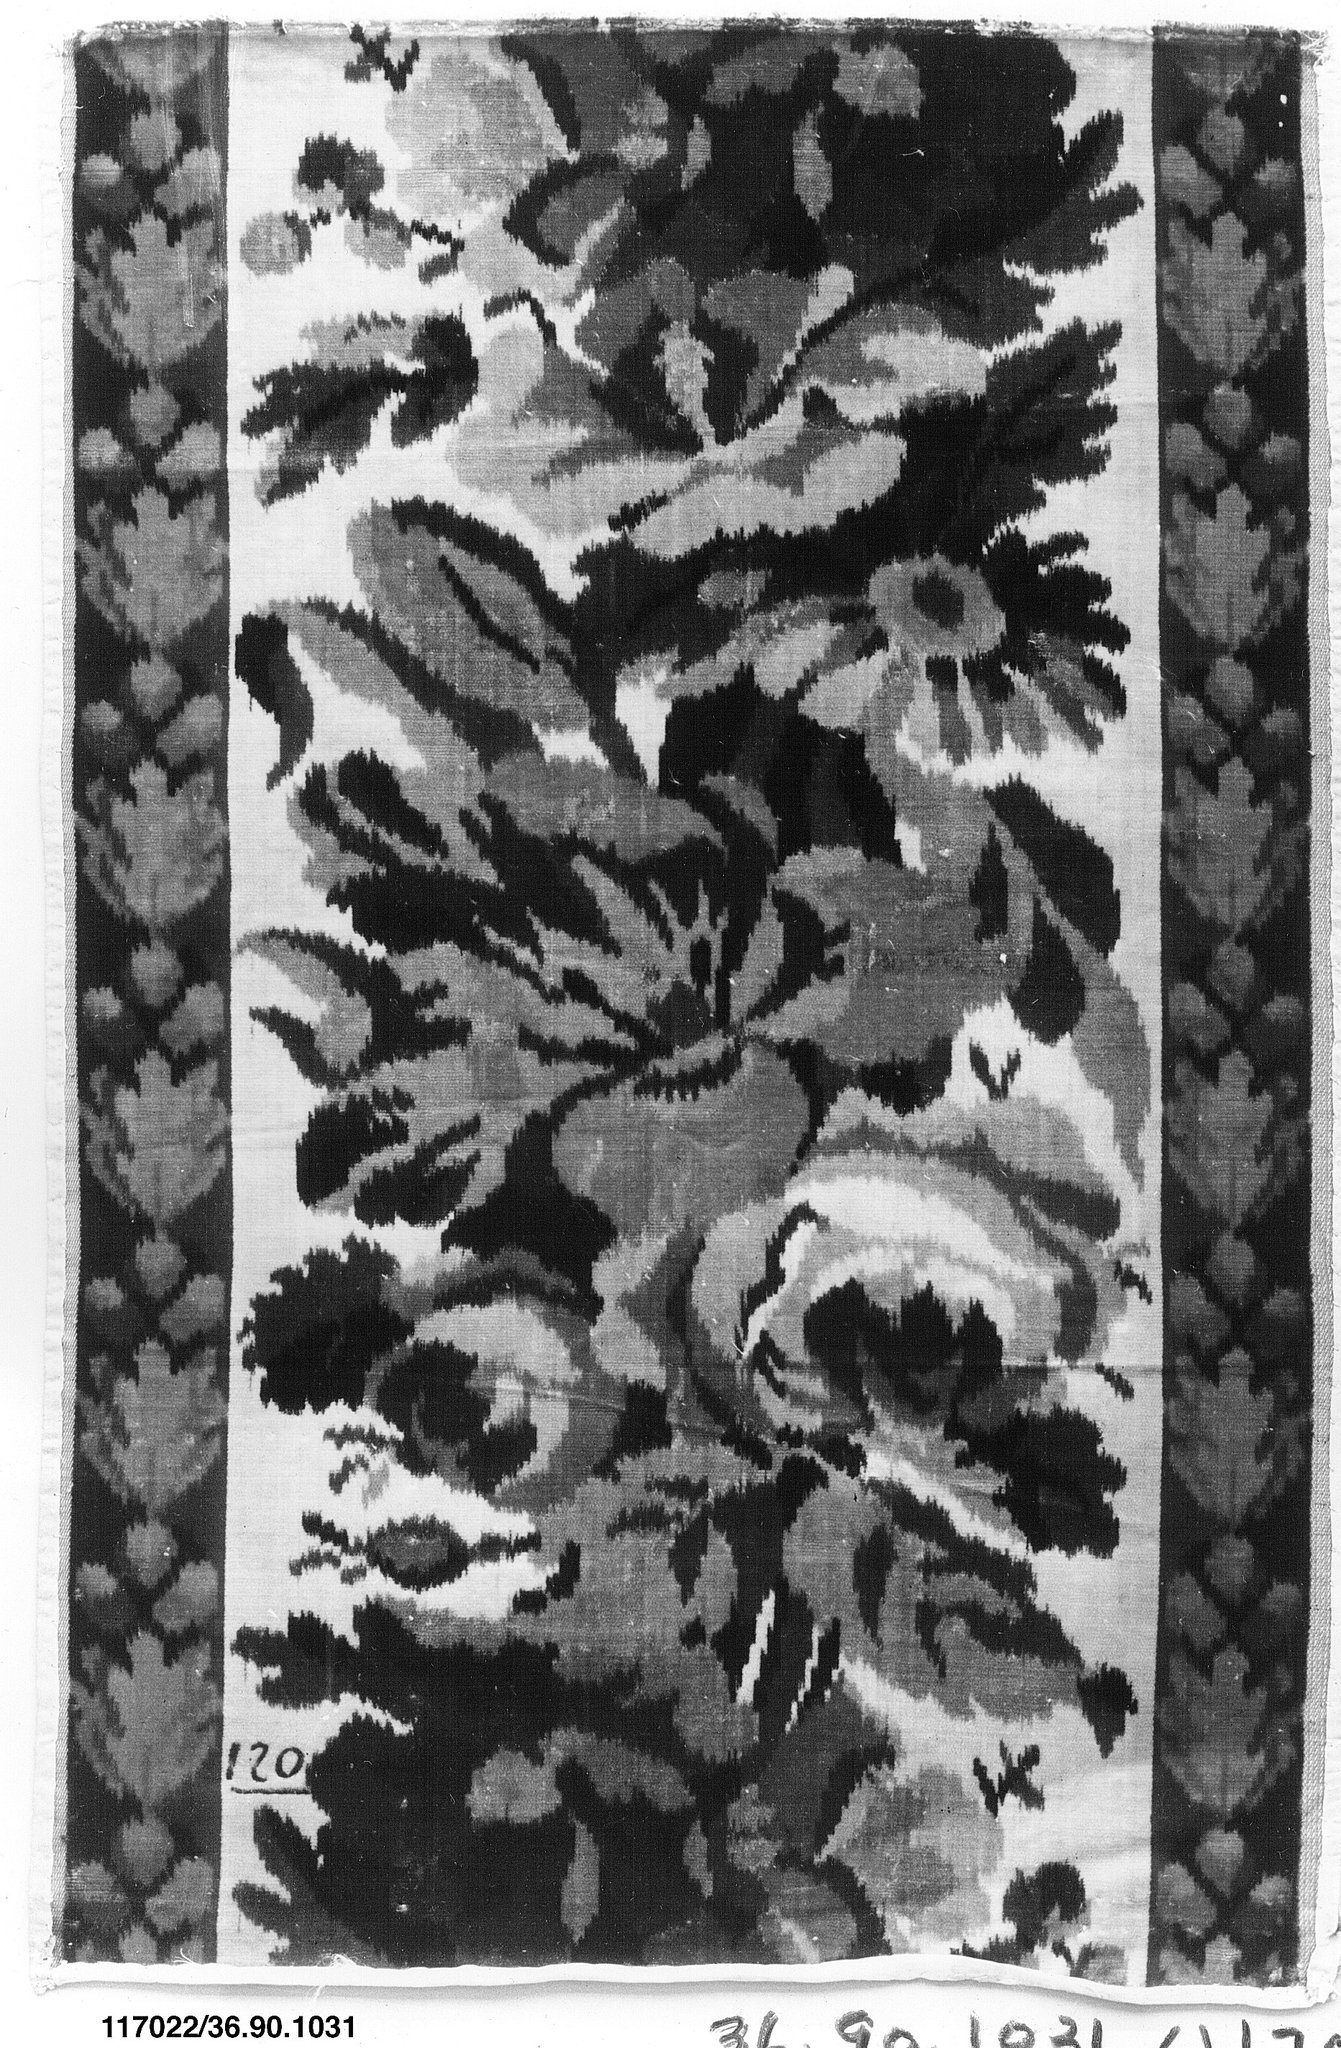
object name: piece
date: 1801-1900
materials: silk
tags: flowers